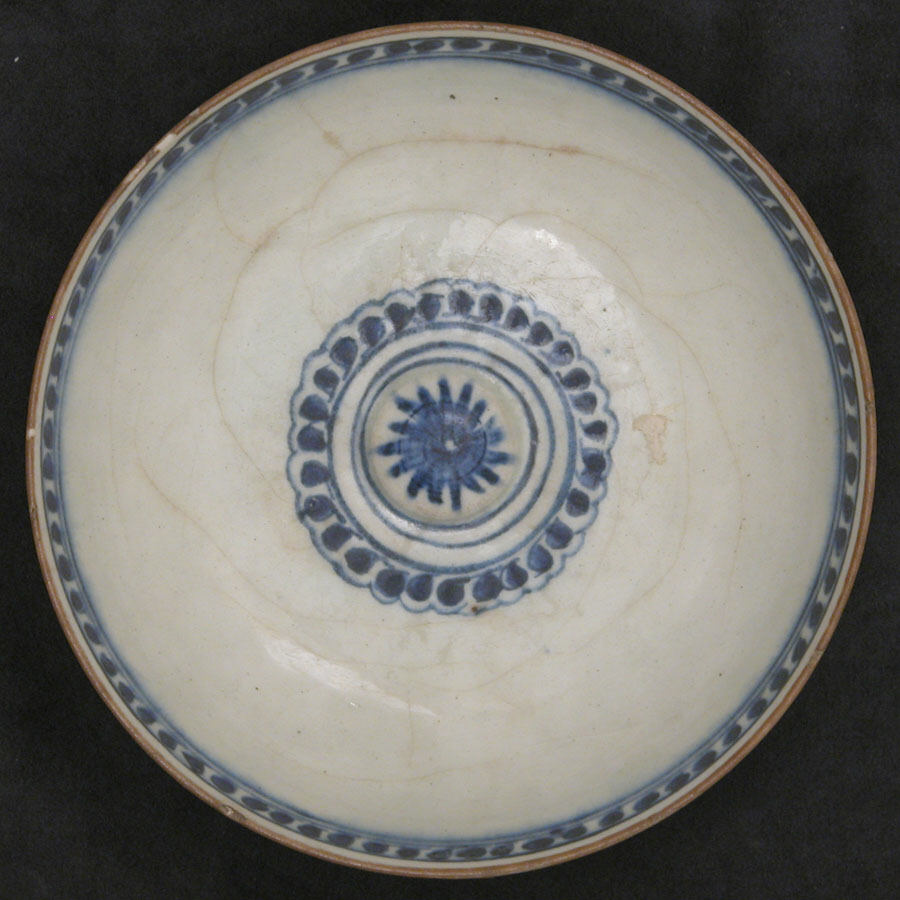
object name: bowl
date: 1601-1700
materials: earthenware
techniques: glazing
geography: iran